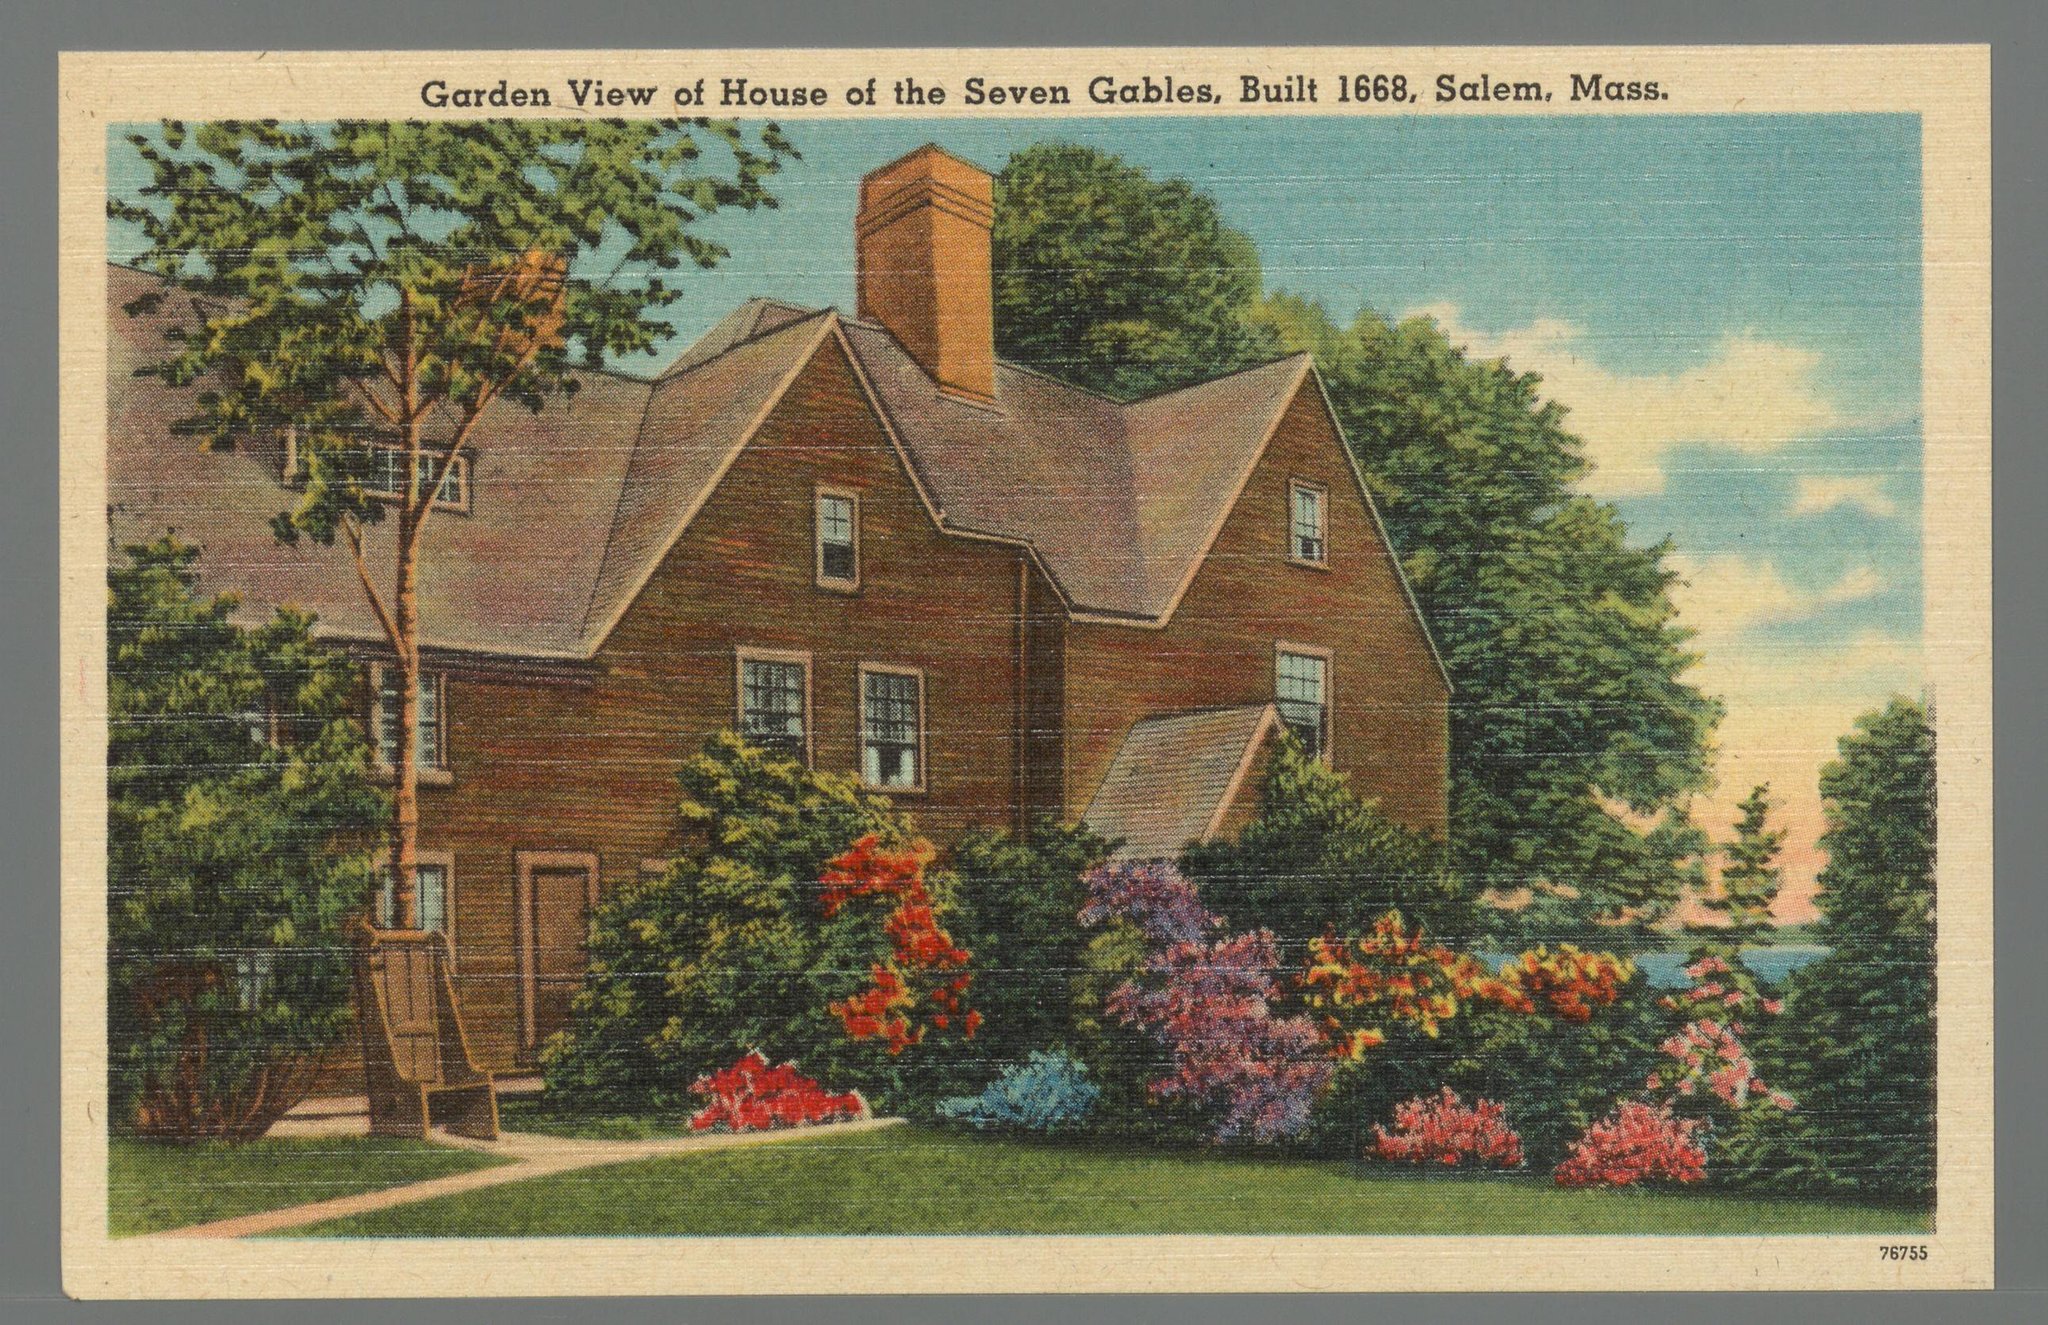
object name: photomechanical print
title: Garden View of House of the Seven Gables, Built 1668. Salem. Mass.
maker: Anonymous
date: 1945-1960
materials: cardboard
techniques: lithograph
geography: boston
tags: garden, exterior ~ representation of a building